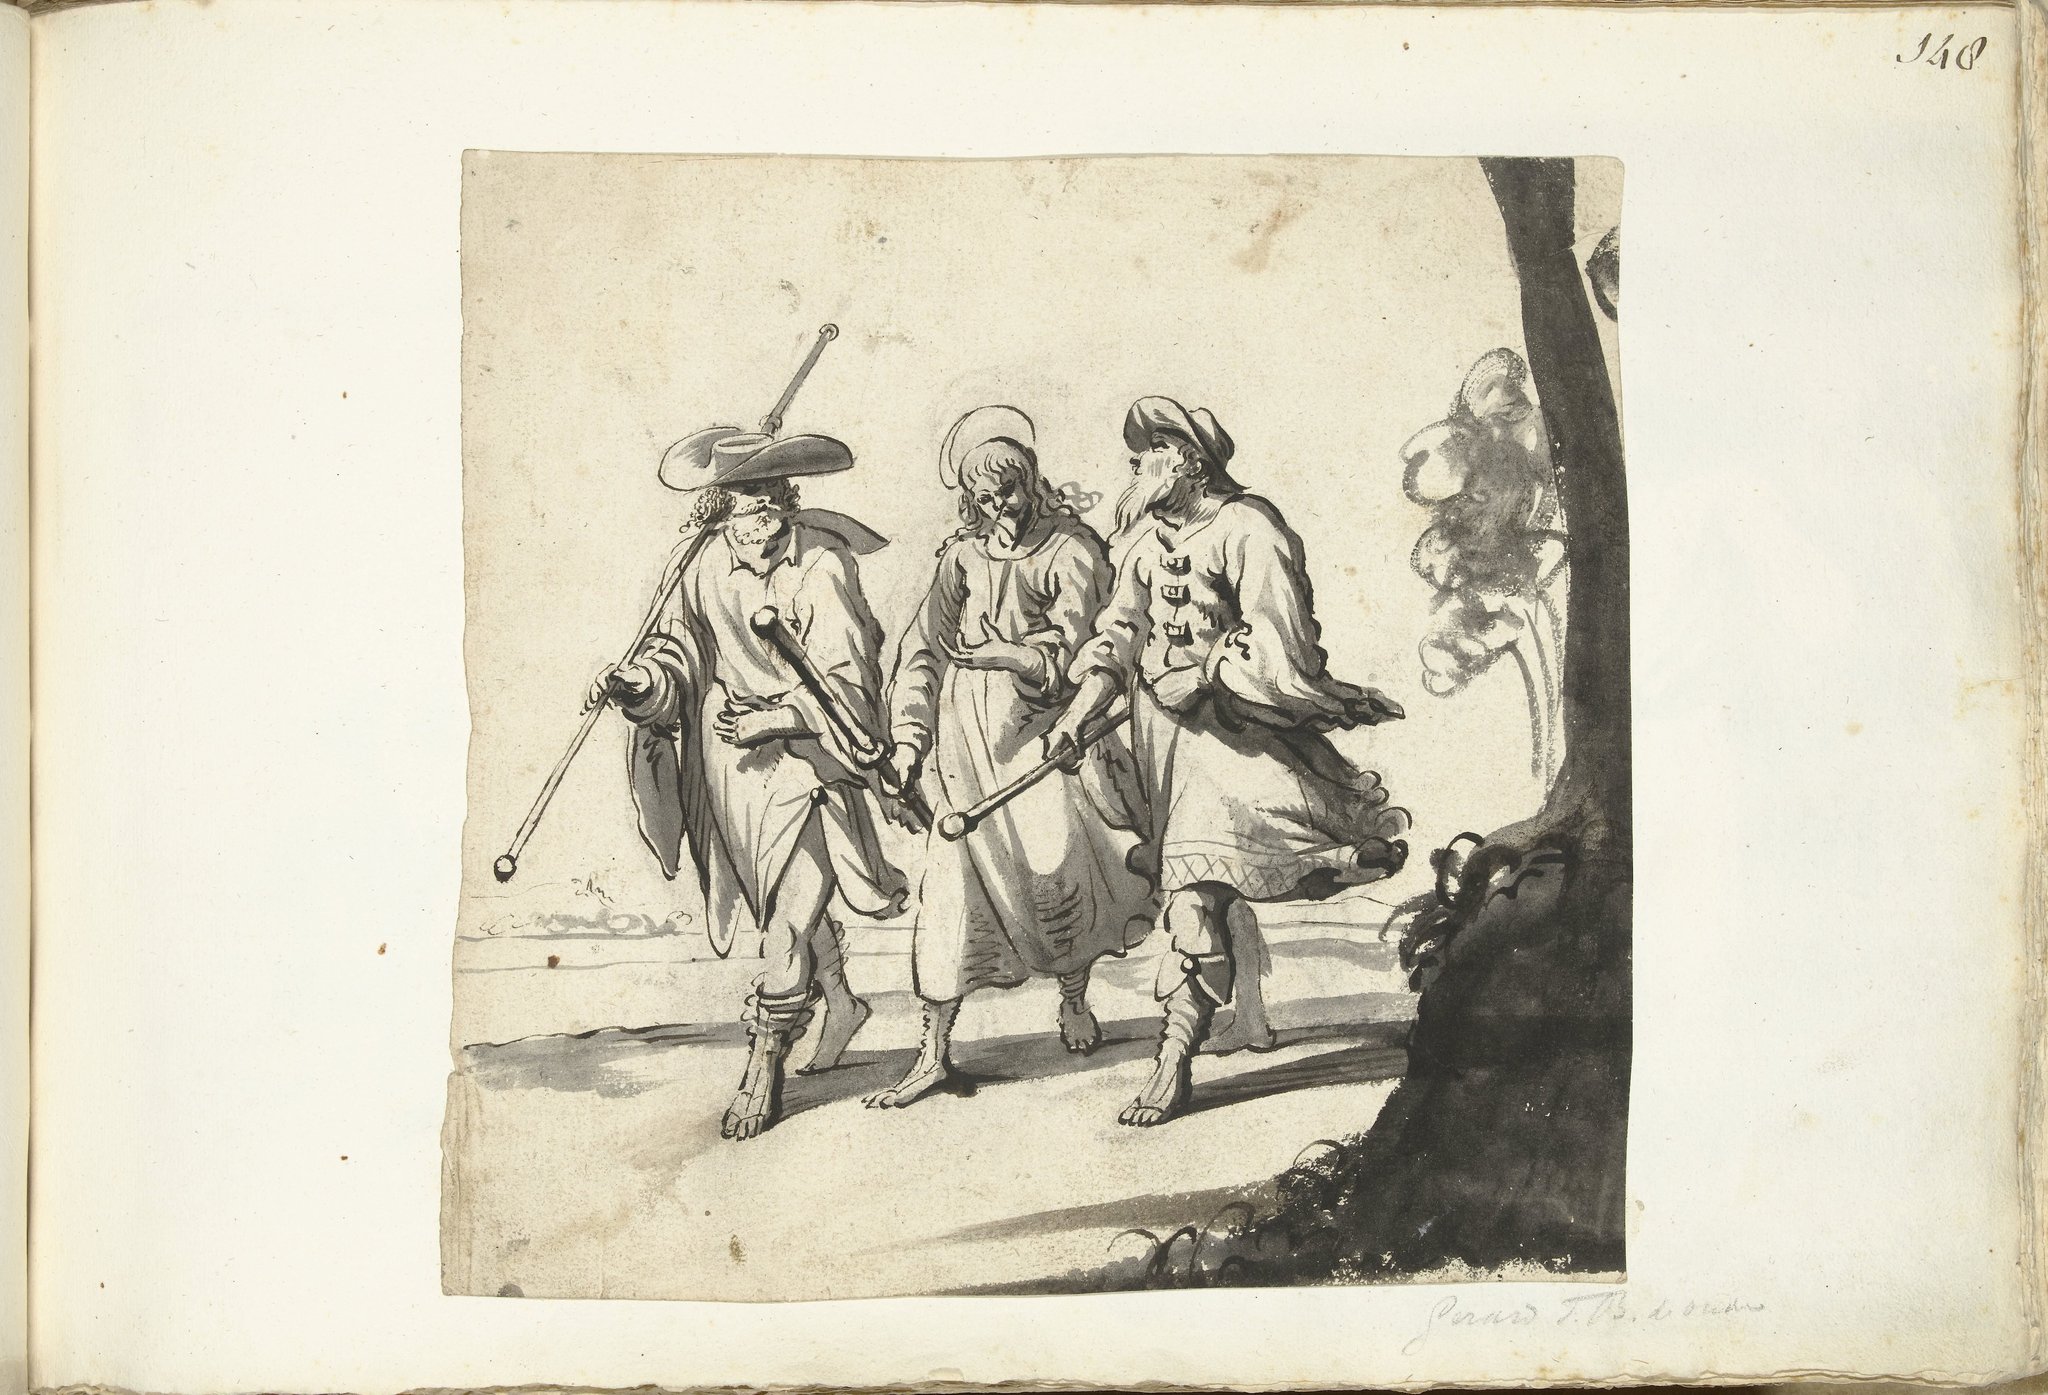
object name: drawing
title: Op weg naar Emmaüs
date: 1648-1677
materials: chalk, ink, paper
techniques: brush